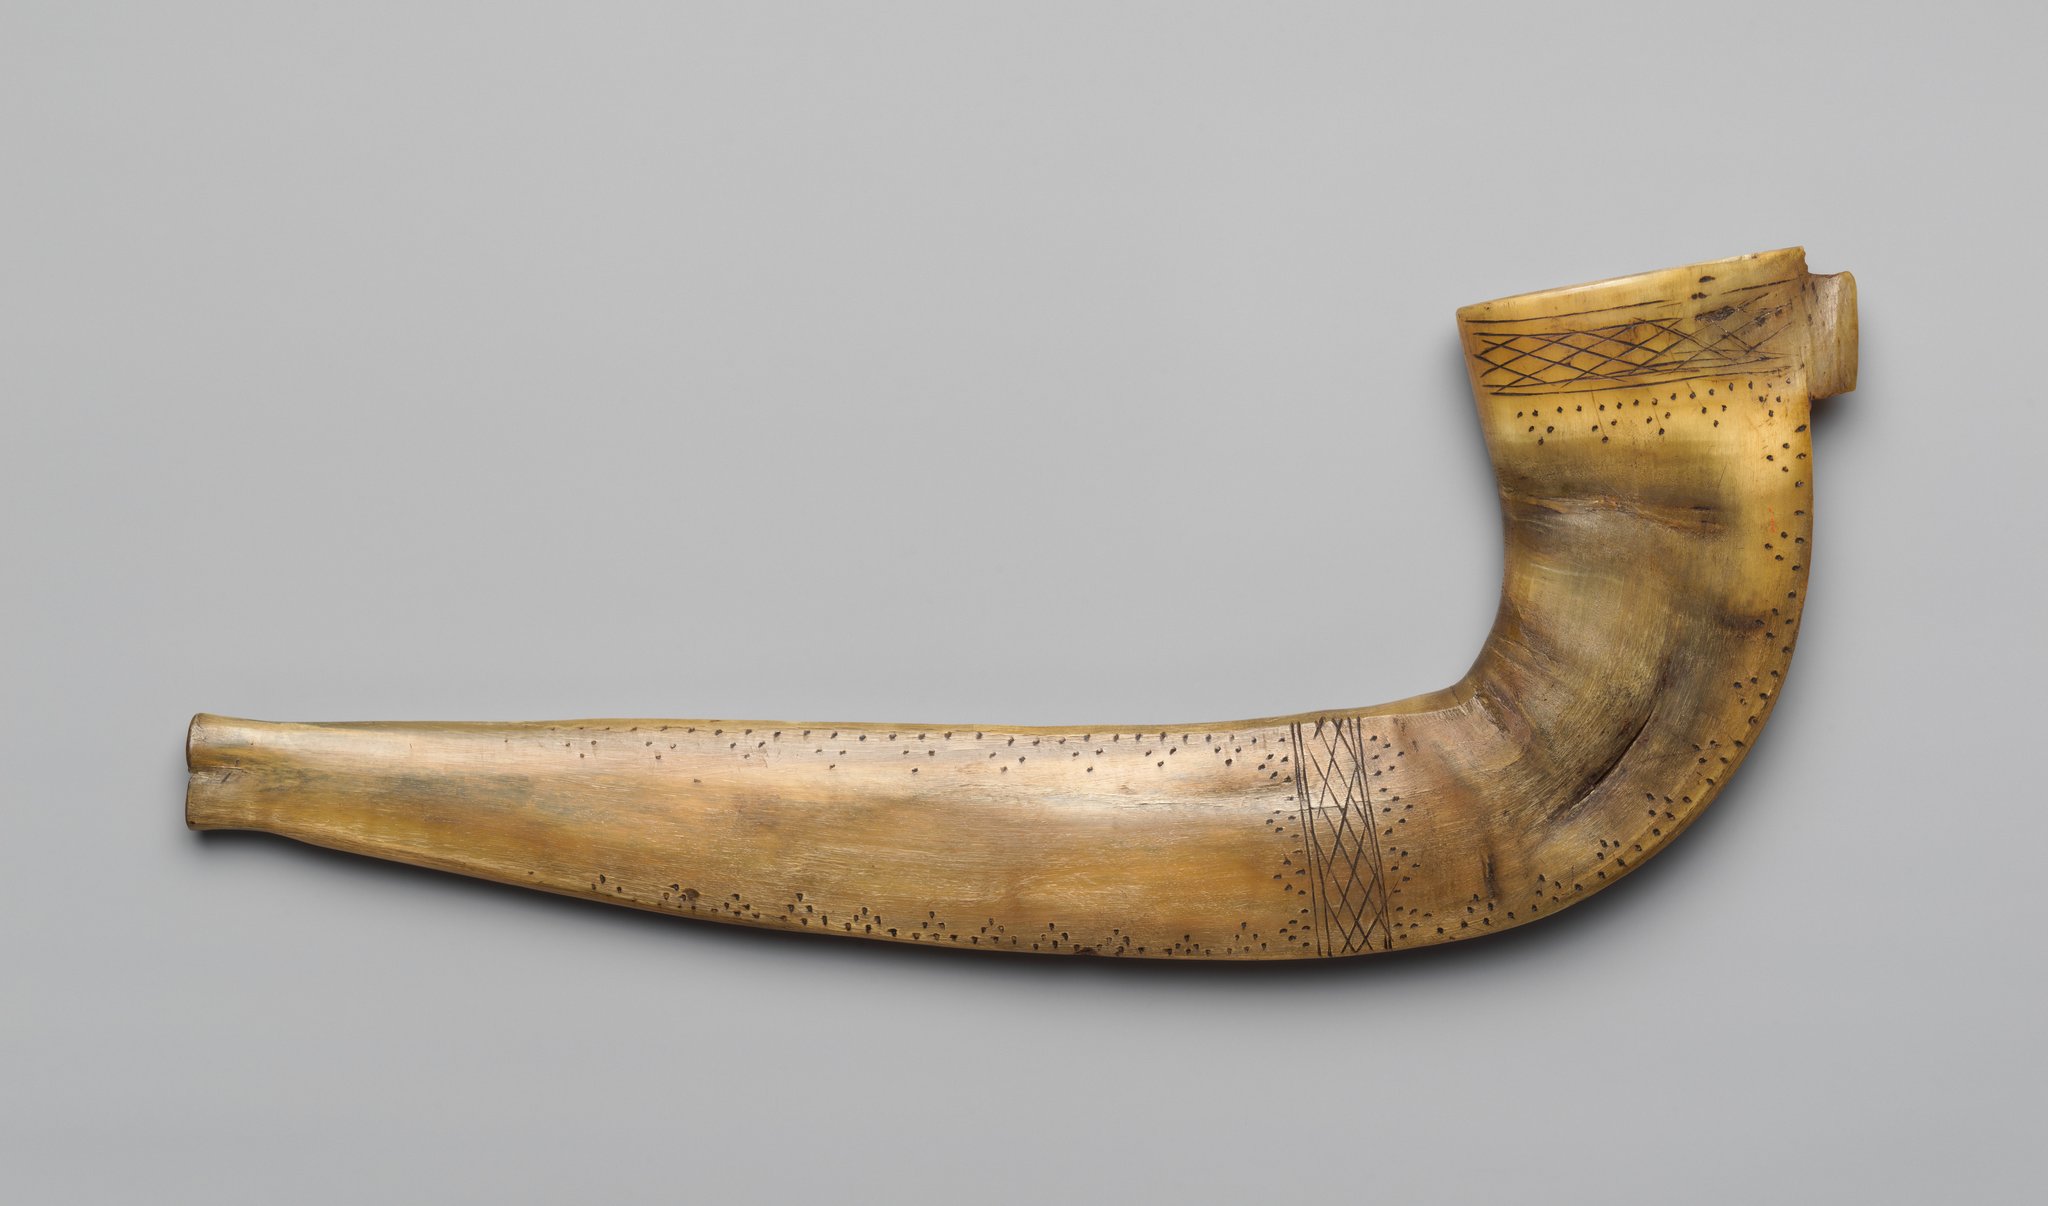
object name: shofar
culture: russian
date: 1801-1900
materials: horn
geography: russia